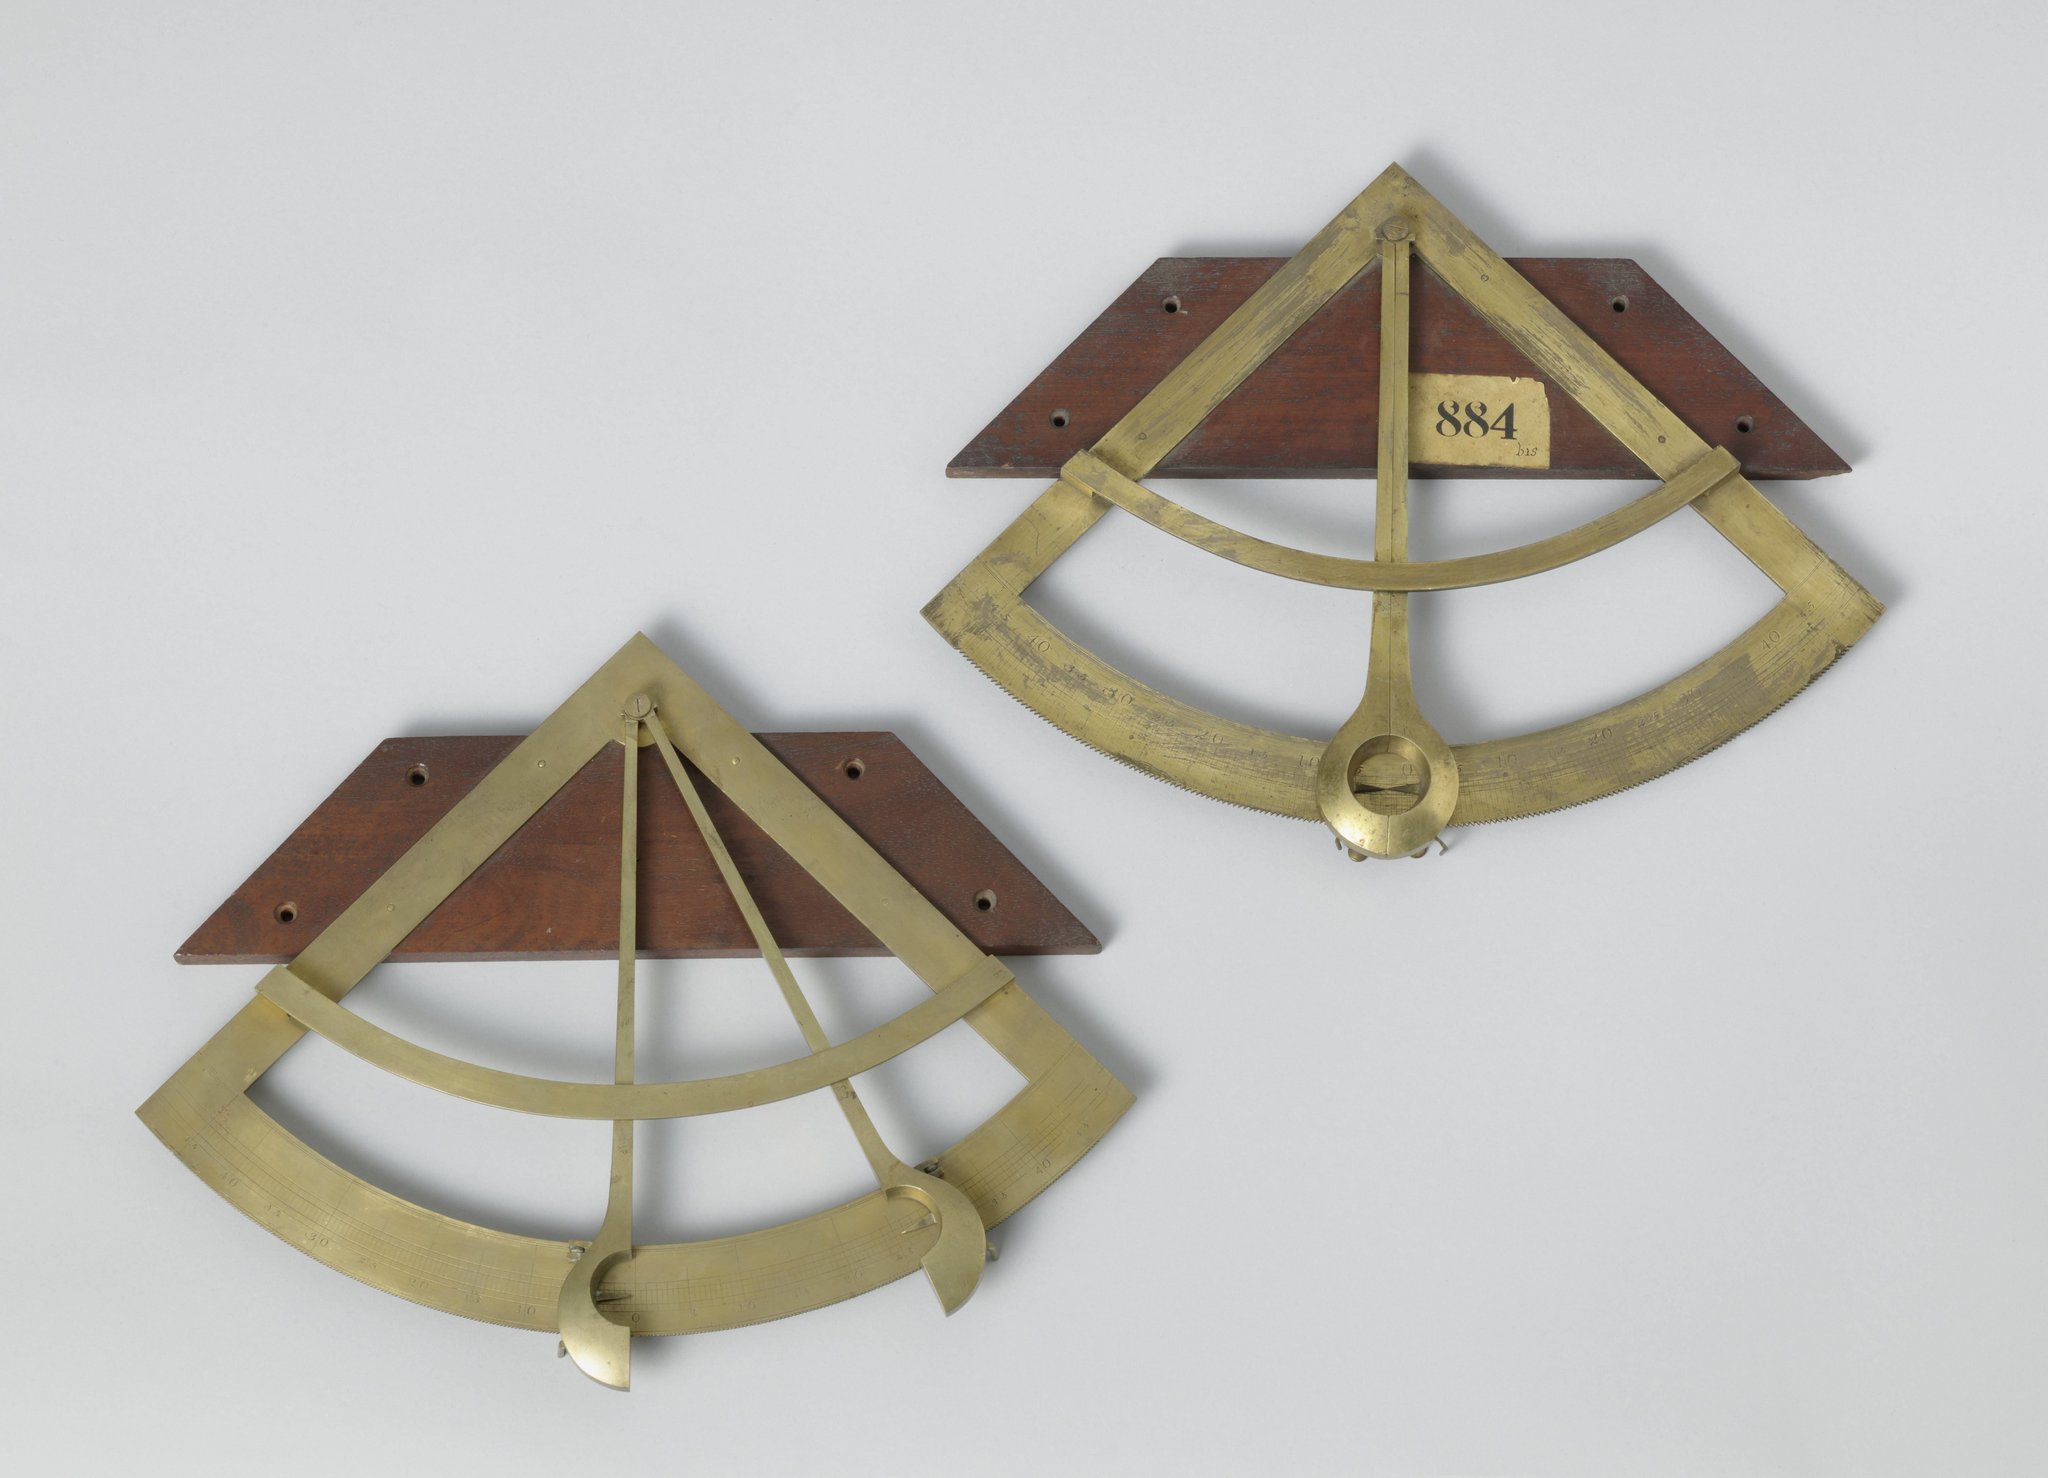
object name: clinometer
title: Two Quadrants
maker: jan marten kleman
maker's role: instrument maker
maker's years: 1758-1845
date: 1793-1808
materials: brass, wood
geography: amsterdam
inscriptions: inscription, on the back of the scale: ‘J:M: Kleman fecit Amsteldam’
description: Twee bijna identieke clinometers om de maximale helling van een slingerend schip te meten. Beide zijn van messing, gemonteerd op een houten achterplaatje met het middelpunt van de boog bovenaan. De schaal op de boog loopt van 0° tot 45° naar iedere kant. De buitenrand van de boog is getand, iedere kant in tegengestelde richting. De twee wijzers hebben pallen tegen de achterkant, die in de tanden grijpen: hierdoor kunnen zij alleen naar buiten bewegen langs de boog. Met de hand kunnen de pallen losgemaakt worden om de wijzers weer naar 0° terug te brengen. Door een kleine onderbreking van de palrand kunnen de wijzers niet in elkaars achtste van de boog terecht komen. De tanden van het kwadrant A verdelen de boog in kwart graden, die op het kwadrant B in halve graden. De wijzers op het kwadrant A lopen met kleine rolletjes over de graadboog. Als het schip slingerde, sloeg iedere wijzer uit naar de kant waar het schip overhelde en gaf de maximum helling aan.